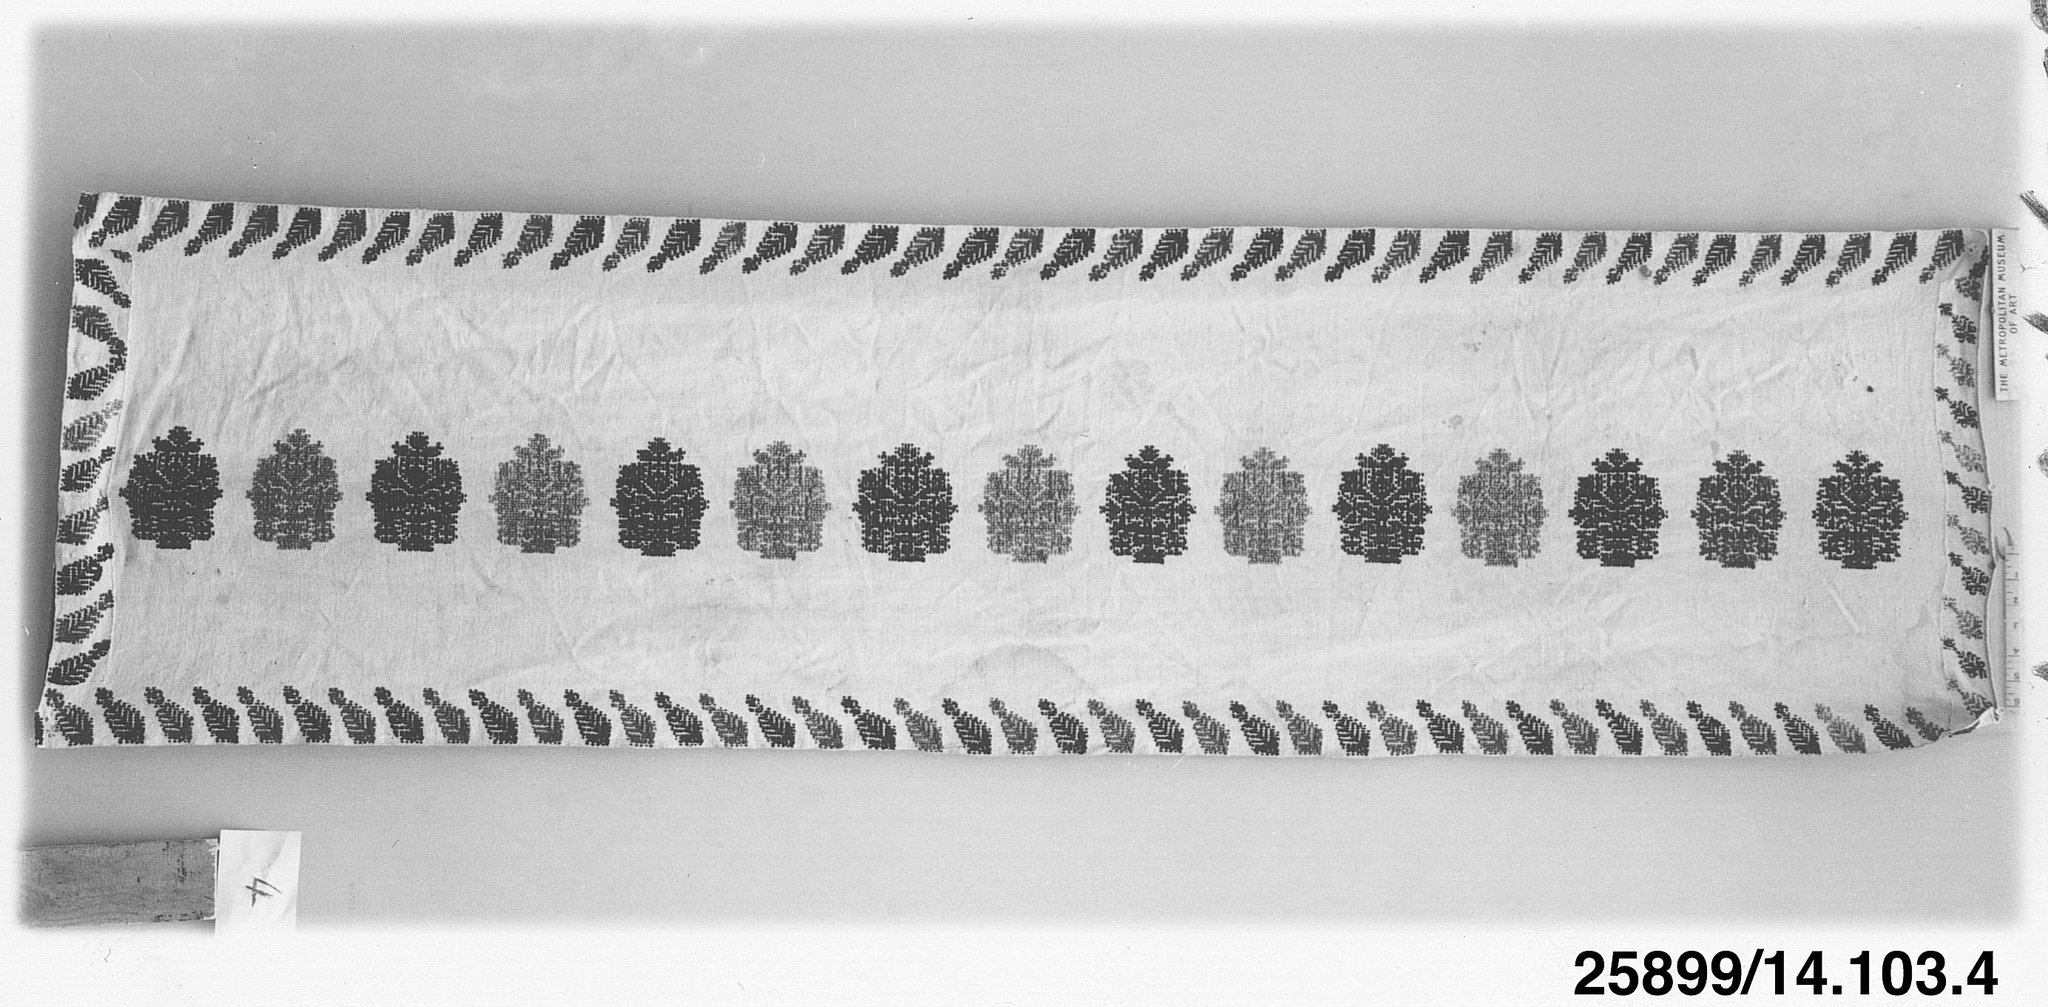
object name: bed valance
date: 1701-1800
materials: linen, silk